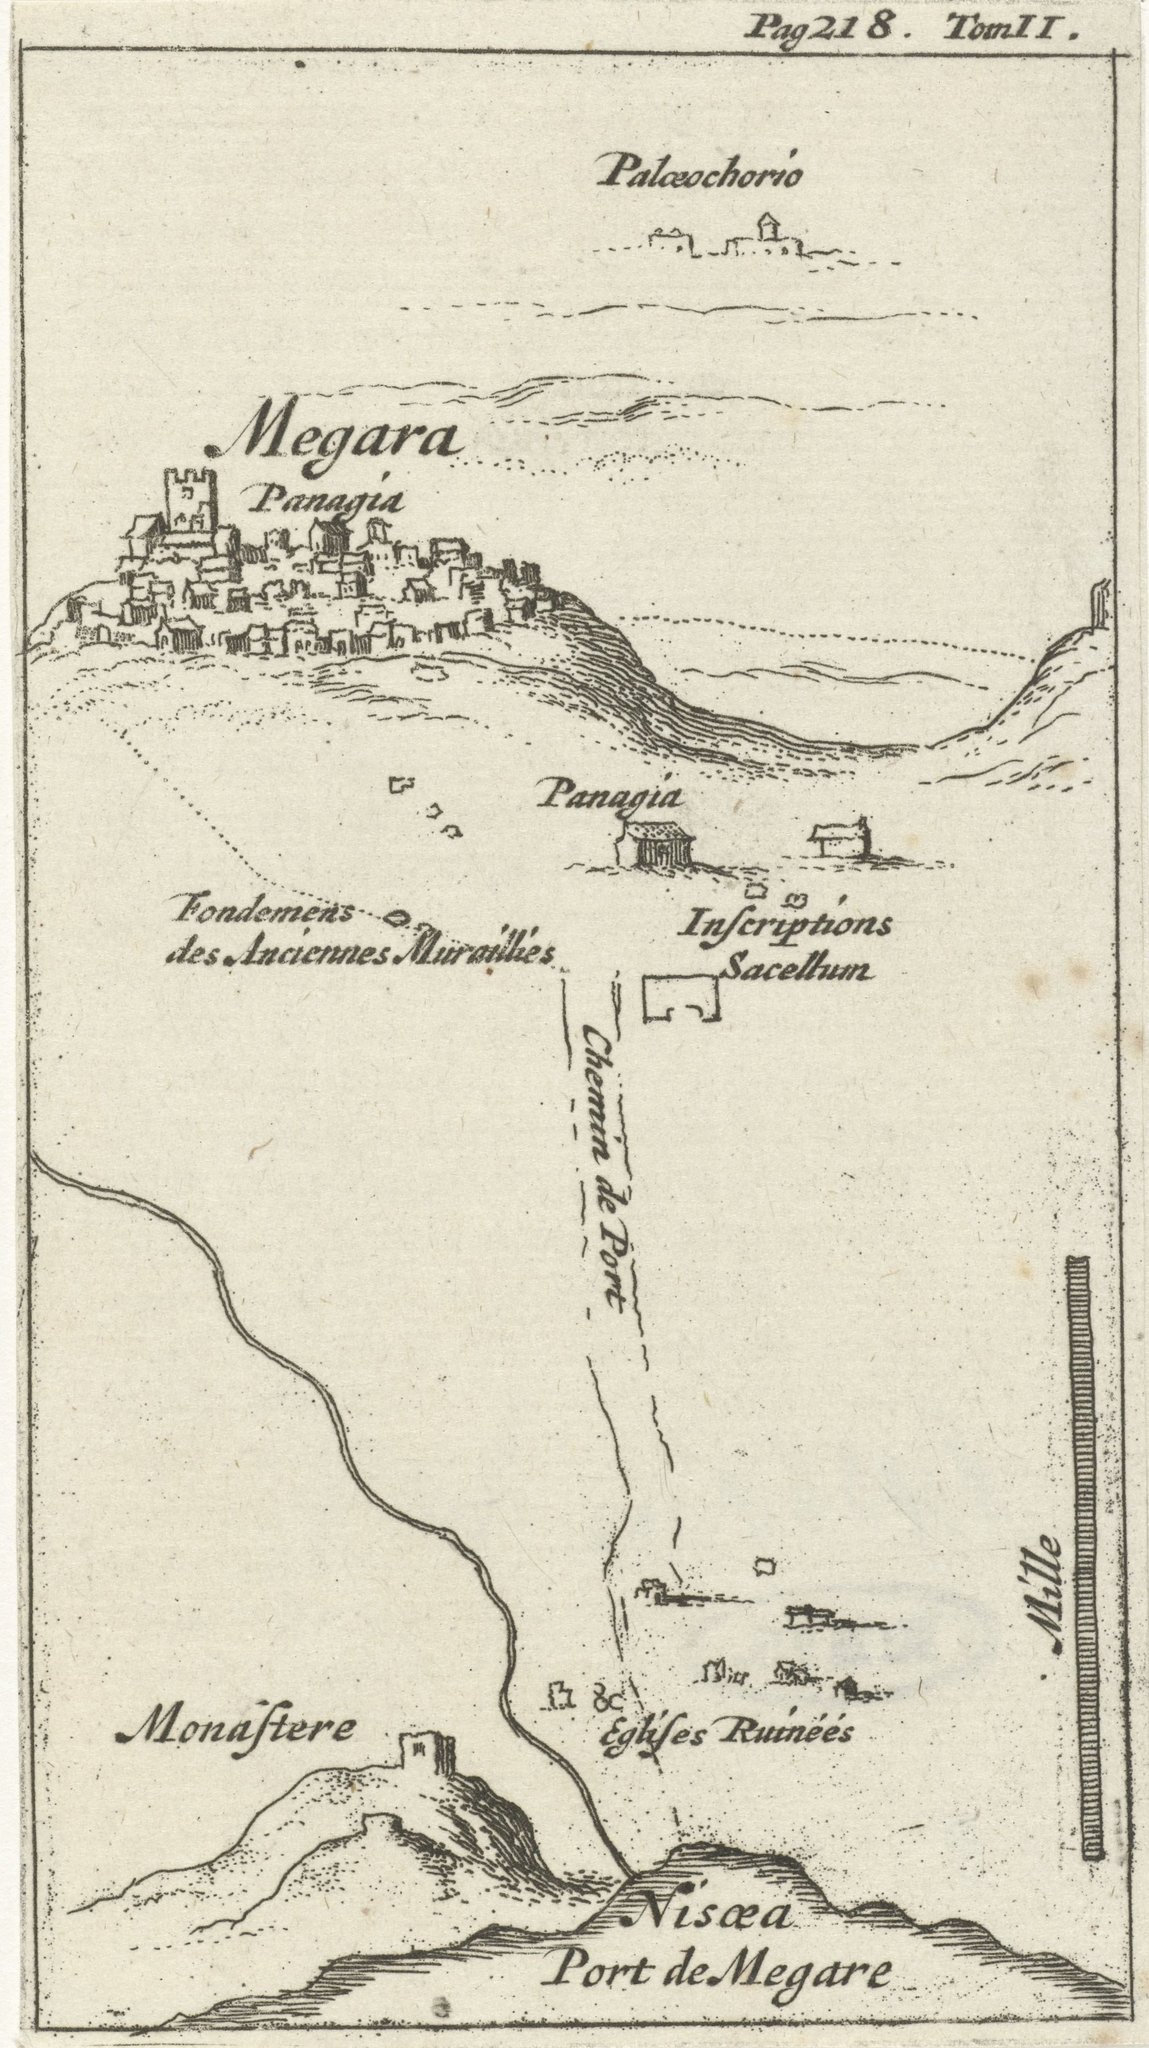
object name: print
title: Megara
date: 1679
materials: paper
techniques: etching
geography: amsterdam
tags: maps of cities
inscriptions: collector's mark: Lugt 2228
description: Illustratie opgenomen in: Spon, Jacob. Voyage d'Italie, de Dalmatie, de Grece, et du Levant, 2 delen, dl. II, p. 218. Amsterdam: Hendrick en Dirk Boom, 1679.